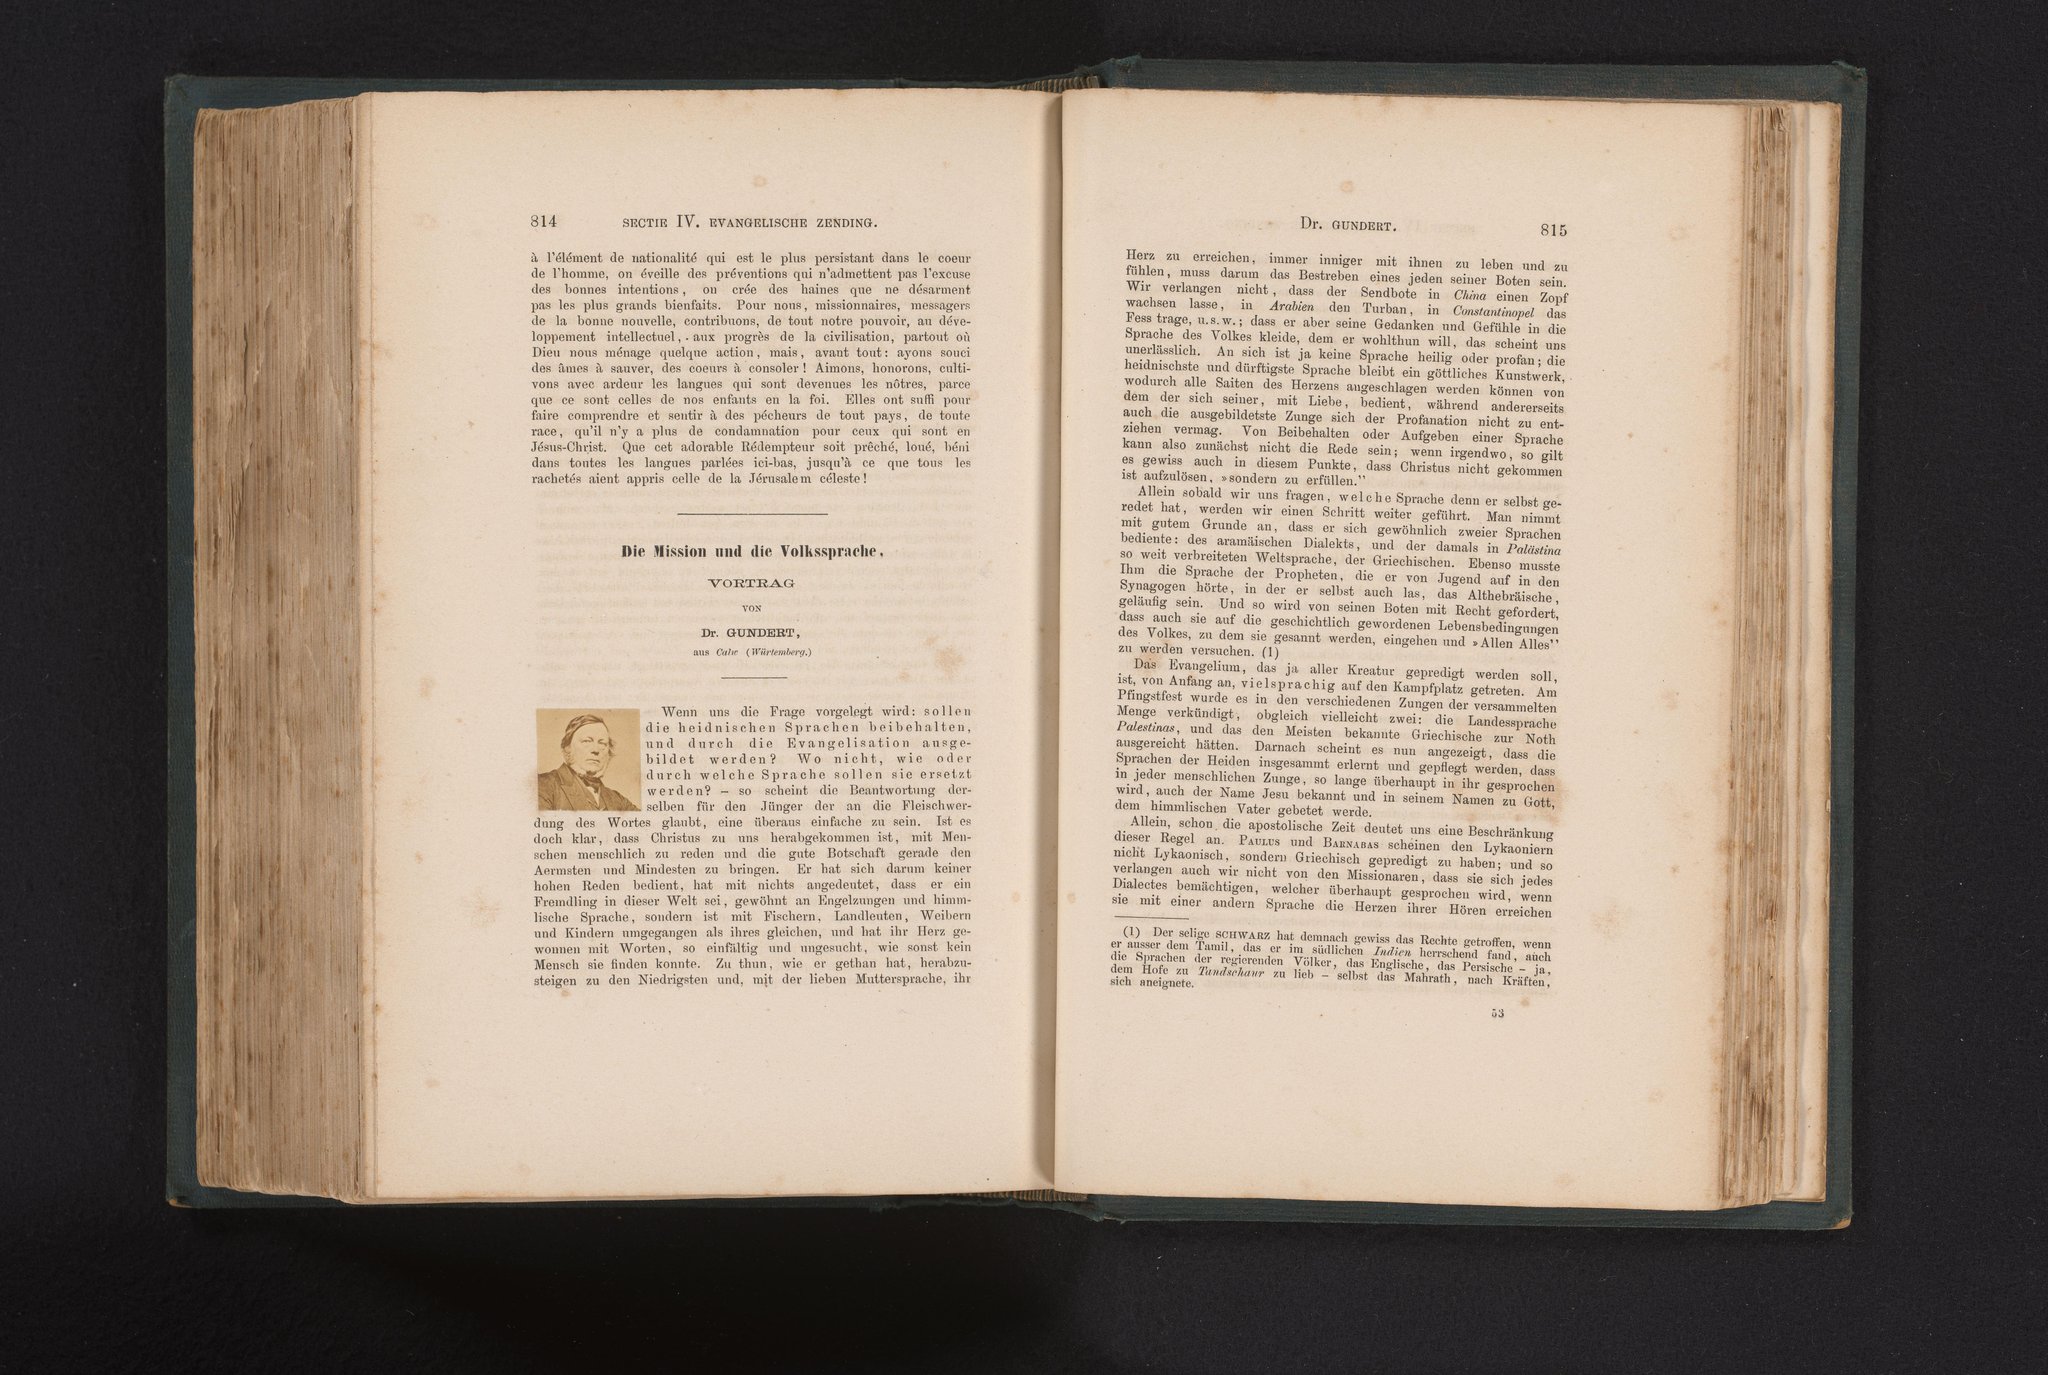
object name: page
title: Portret van Hermann Gundert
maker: Anonymous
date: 1855-1867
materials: paper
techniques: albumen print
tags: missionary, adult man, historical persons